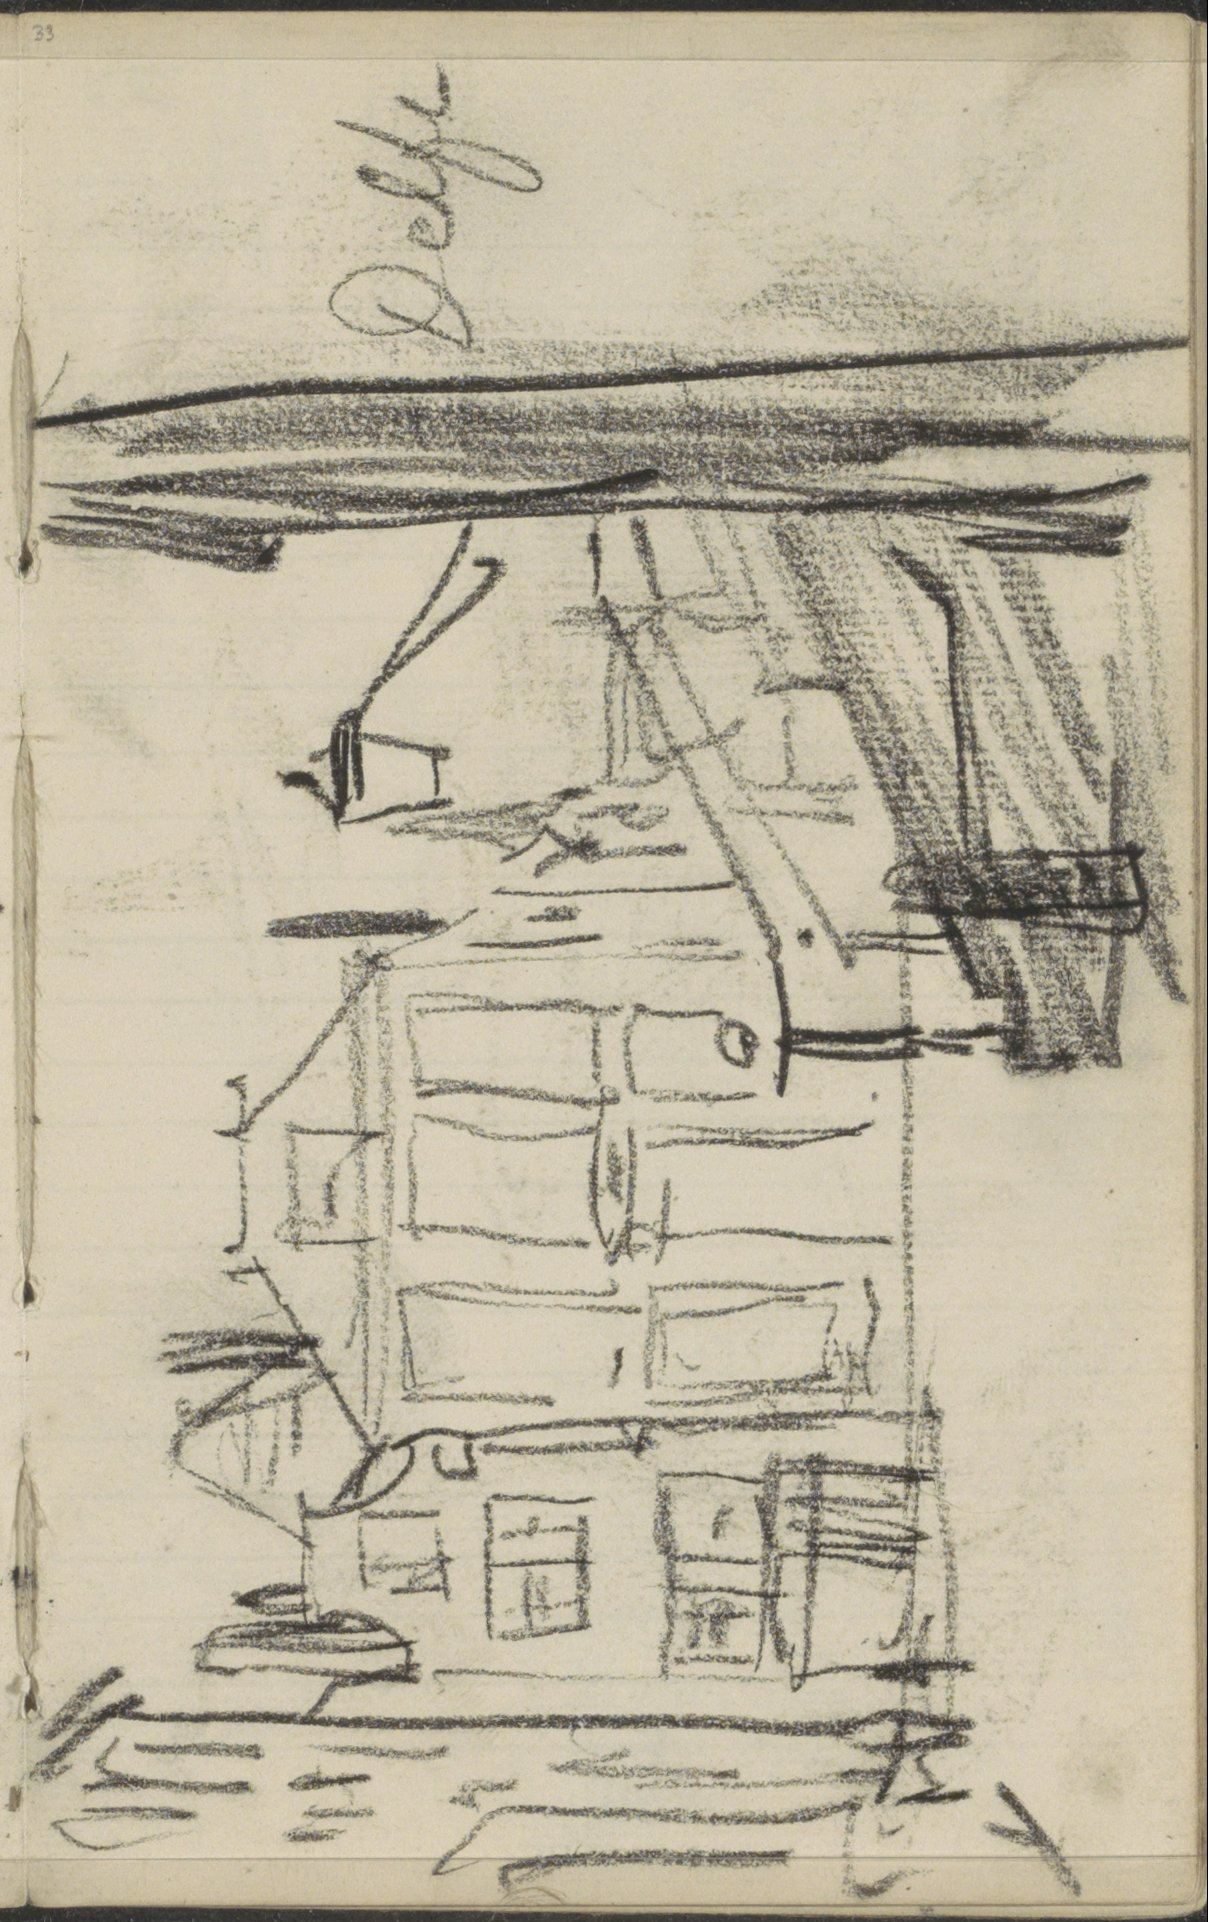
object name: sketchbook leaf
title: Straat in Delft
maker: marius bauer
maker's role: draughtsman, print maker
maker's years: 1867-1932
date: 1881-1885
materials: chalk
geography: delft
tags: flight of steps, street lighting, street, delft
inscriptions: annotation: ‘Delft’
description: Pagina 33 uit een schetsboek met 26 bladen.